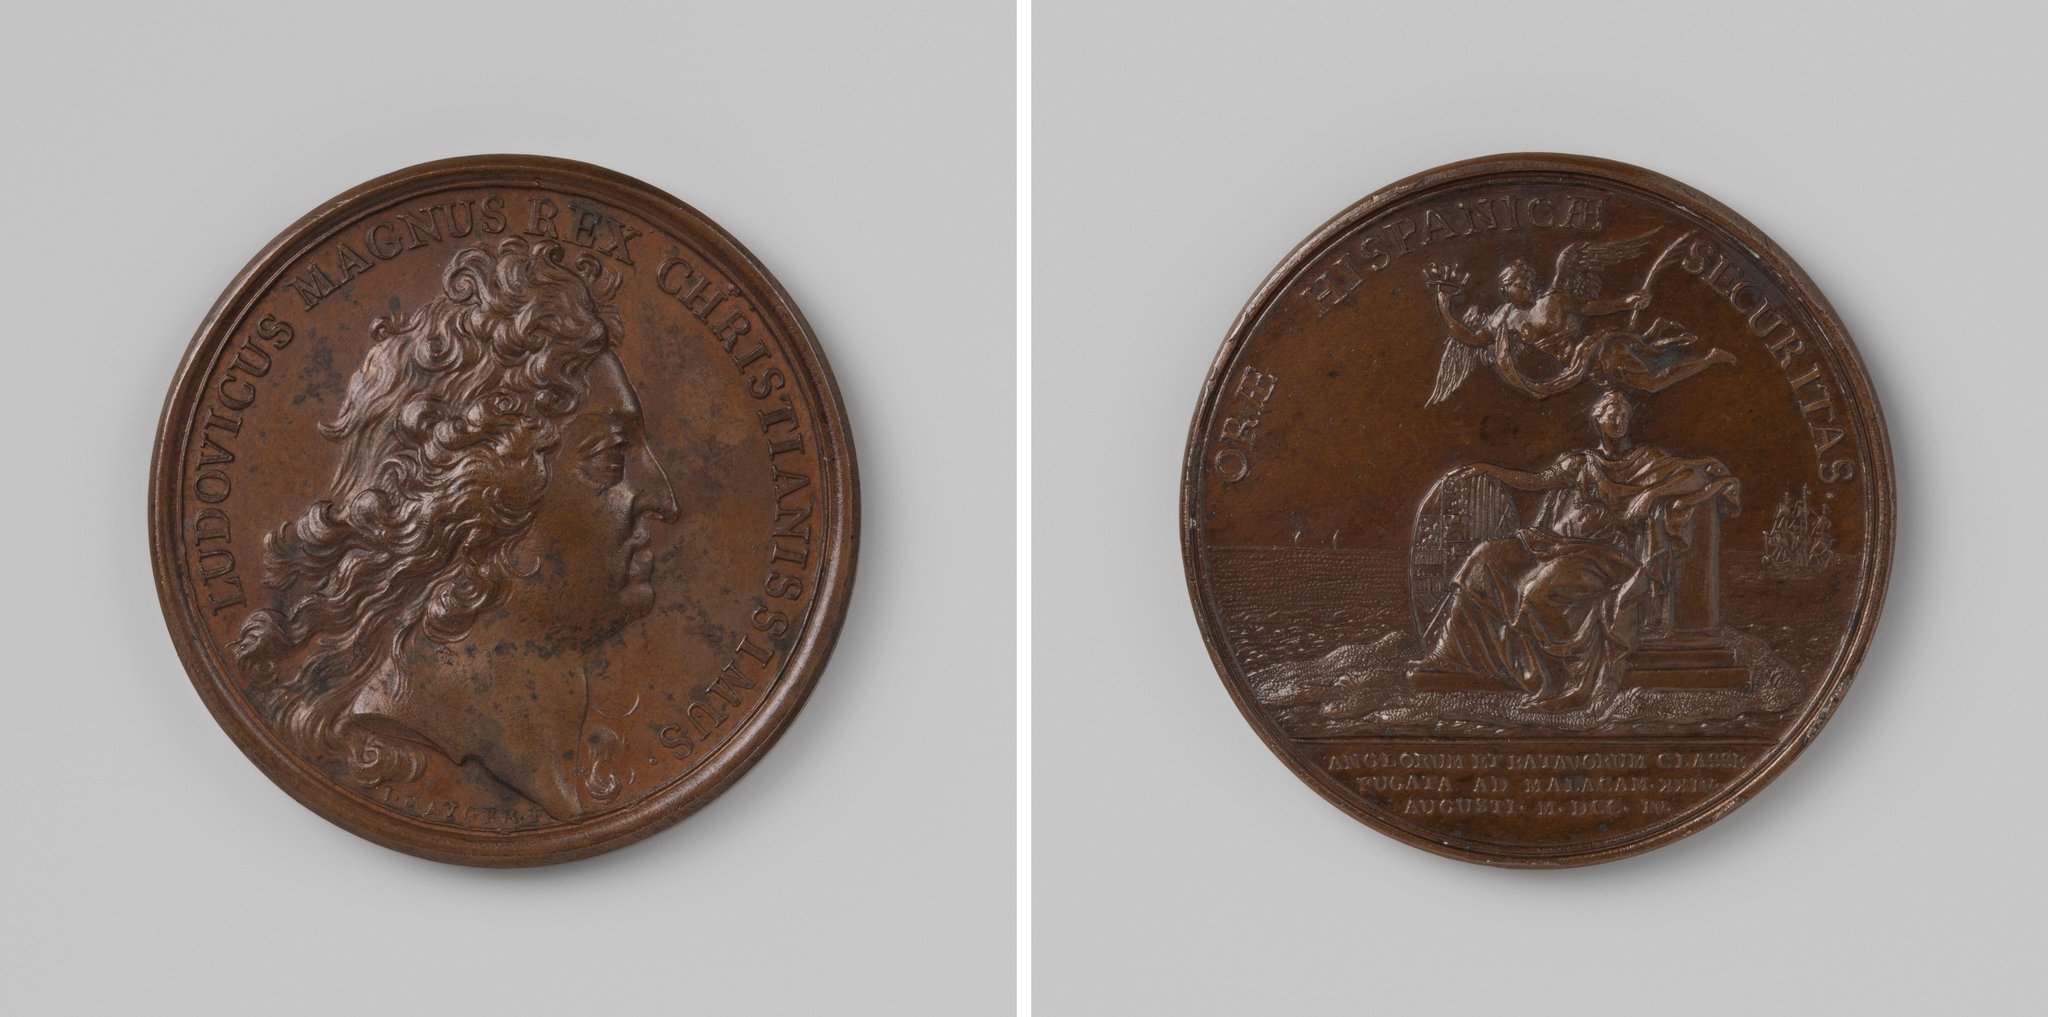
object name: history medal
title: Engelse en Nederlandse vloot bij Malaga verslagen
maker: jean mauger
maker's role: medailleur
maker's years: 1648-1722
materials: bronze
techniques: striking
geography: paris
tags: lodewijk xiv (koning van frankrijk), spain